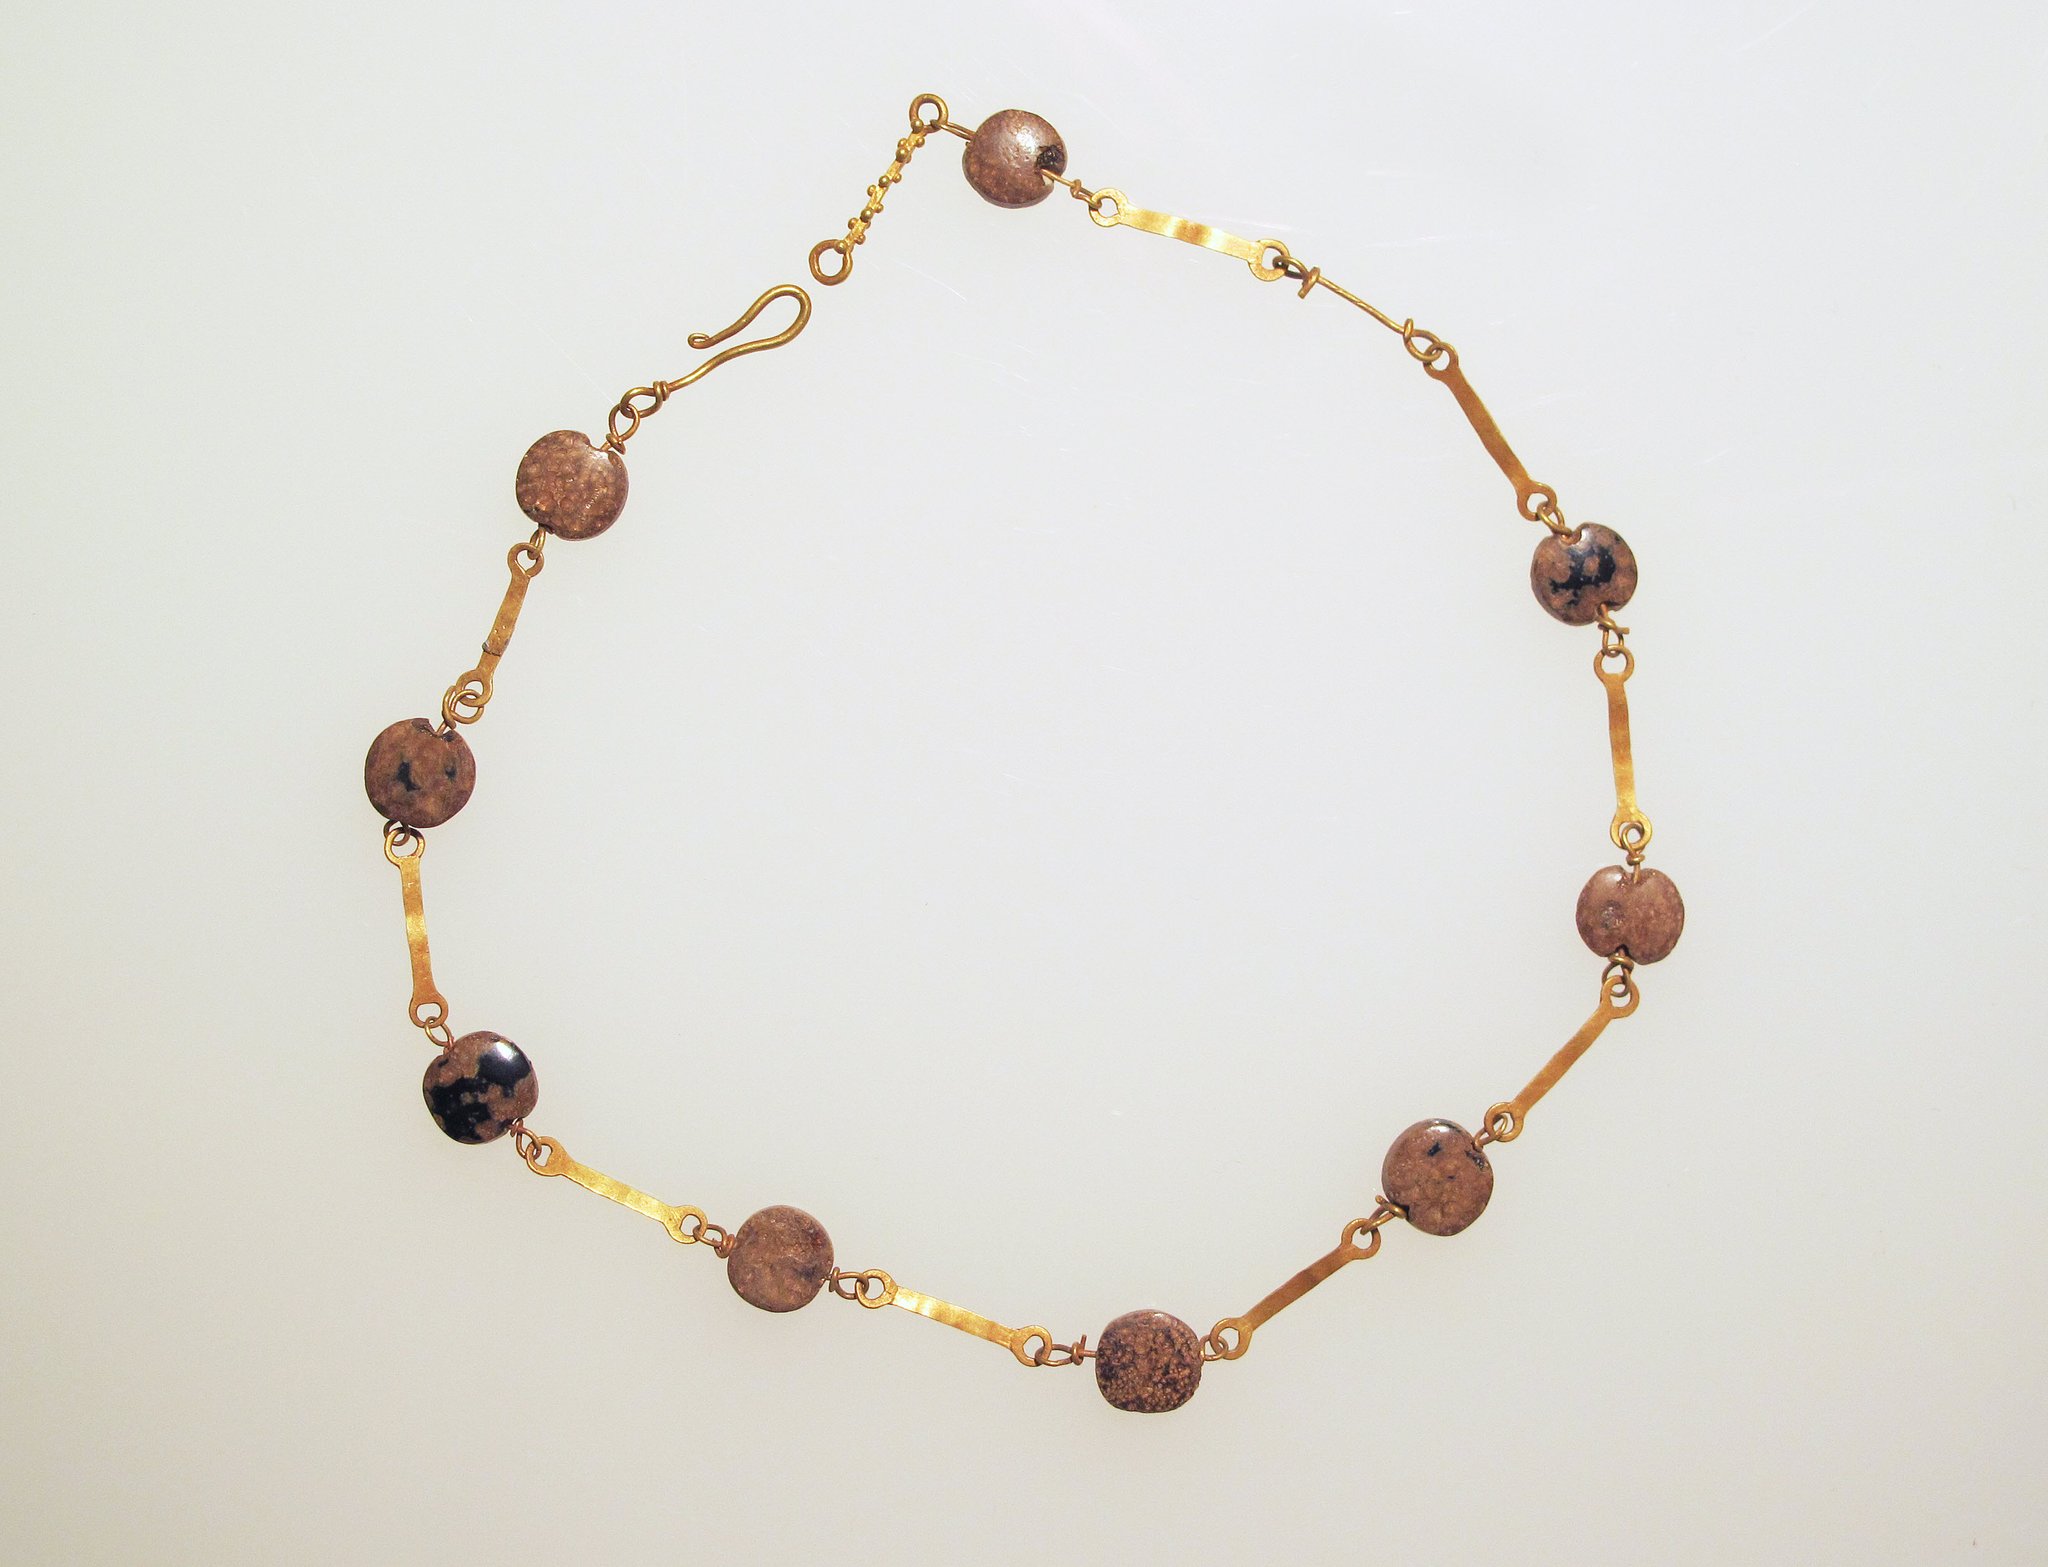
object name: necklace with paste bead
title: Necklace with paste beads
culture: roman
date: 101-200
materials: glass, gold, paste